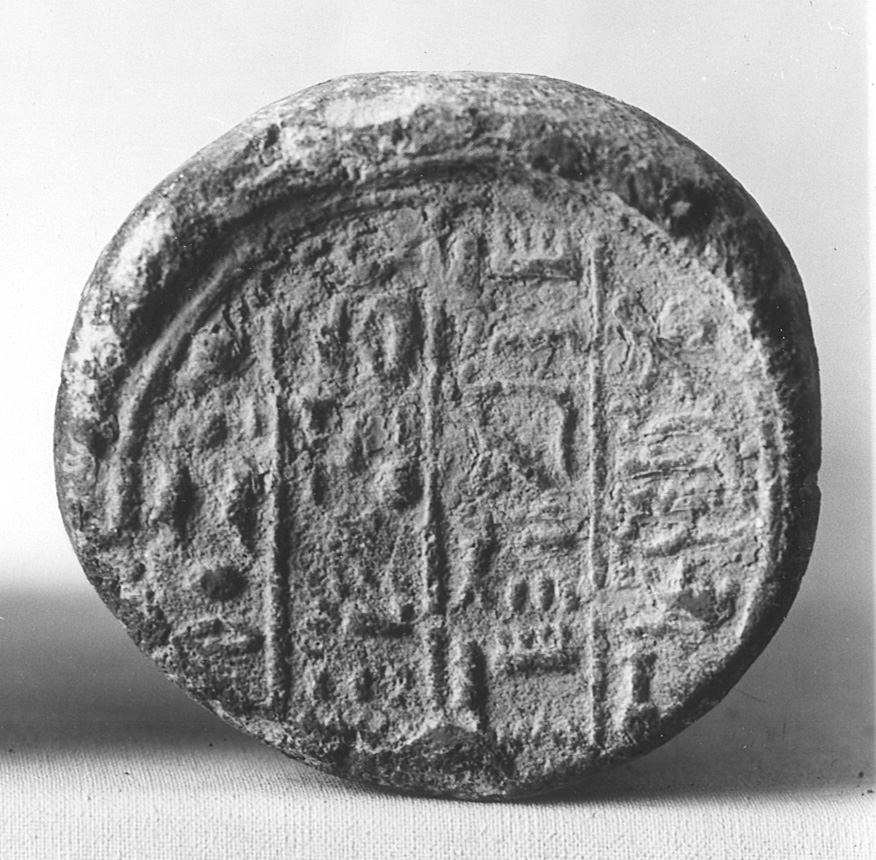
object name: cone, circular impression, amenemopet, tjanefer, scribe, amun, overseer, field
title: Funerary Cone of Amenemopet called Tjanefer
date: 1550-1352 BCE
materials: pottery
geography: egypt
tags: hieroglyphs